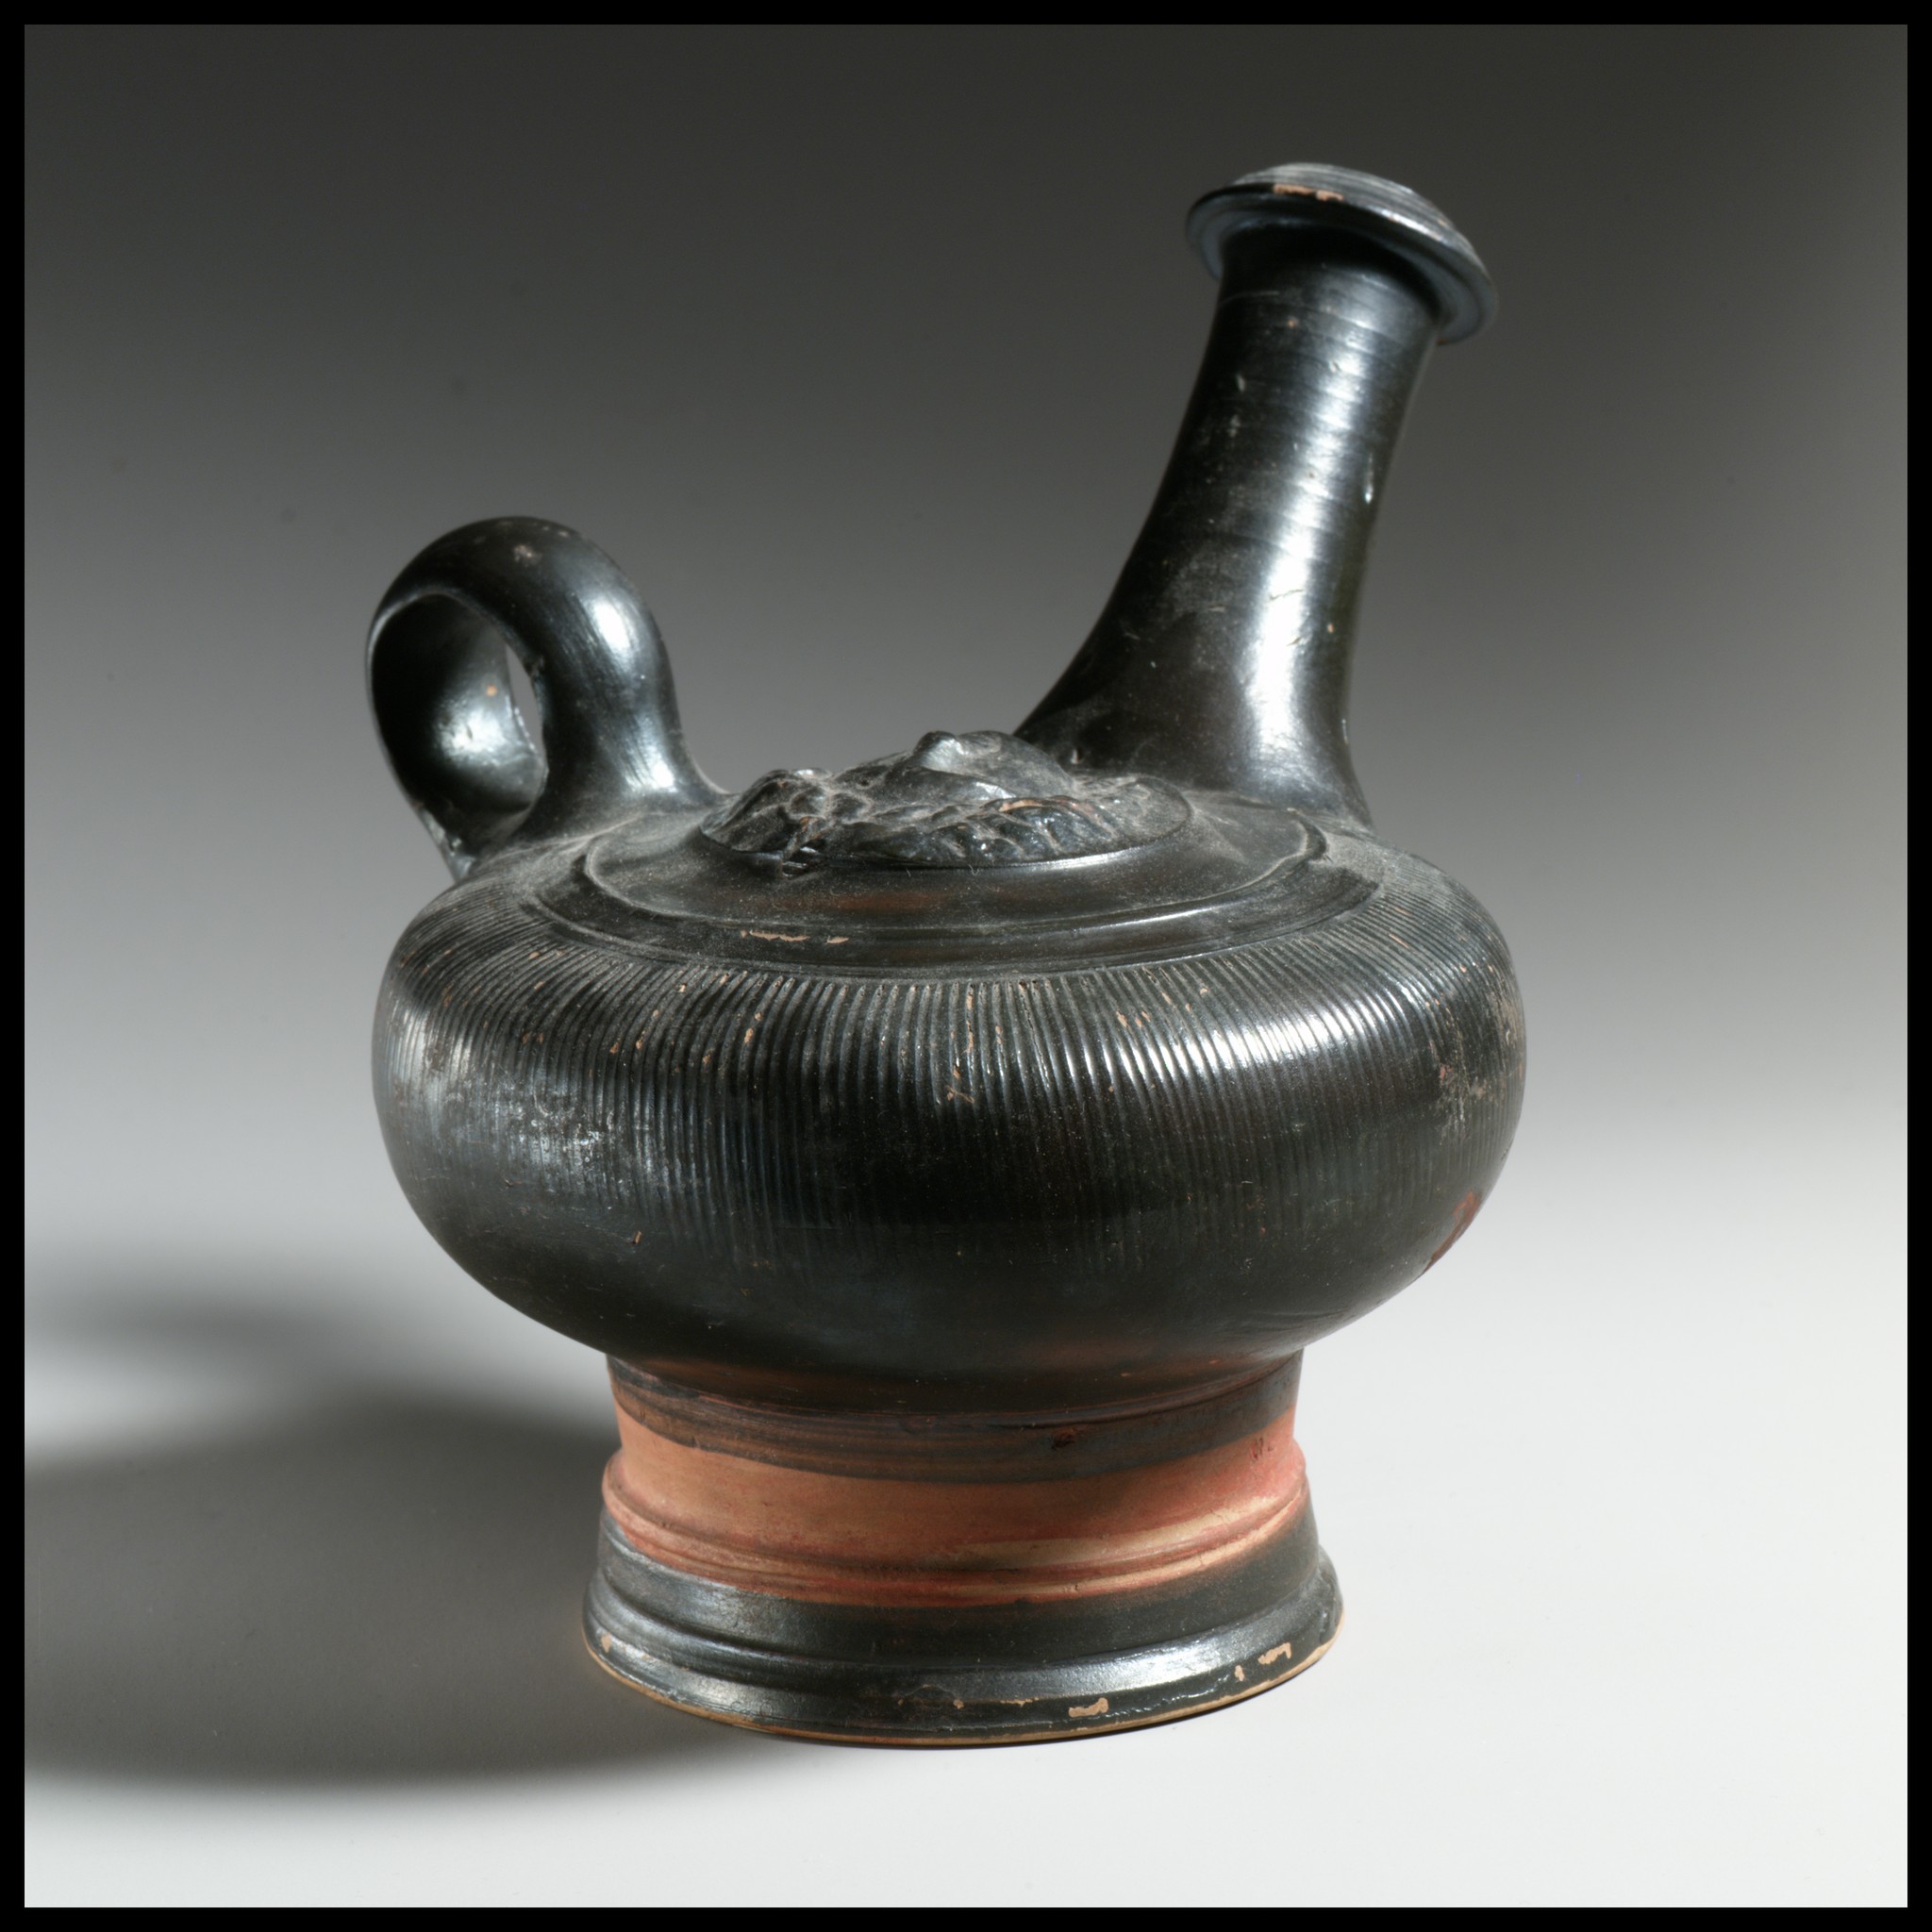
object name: guttus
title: Terracotta guttus (flask with handle and vertical spout)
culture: greek or south italian or campanian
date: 400-301 BCE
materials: terracotta